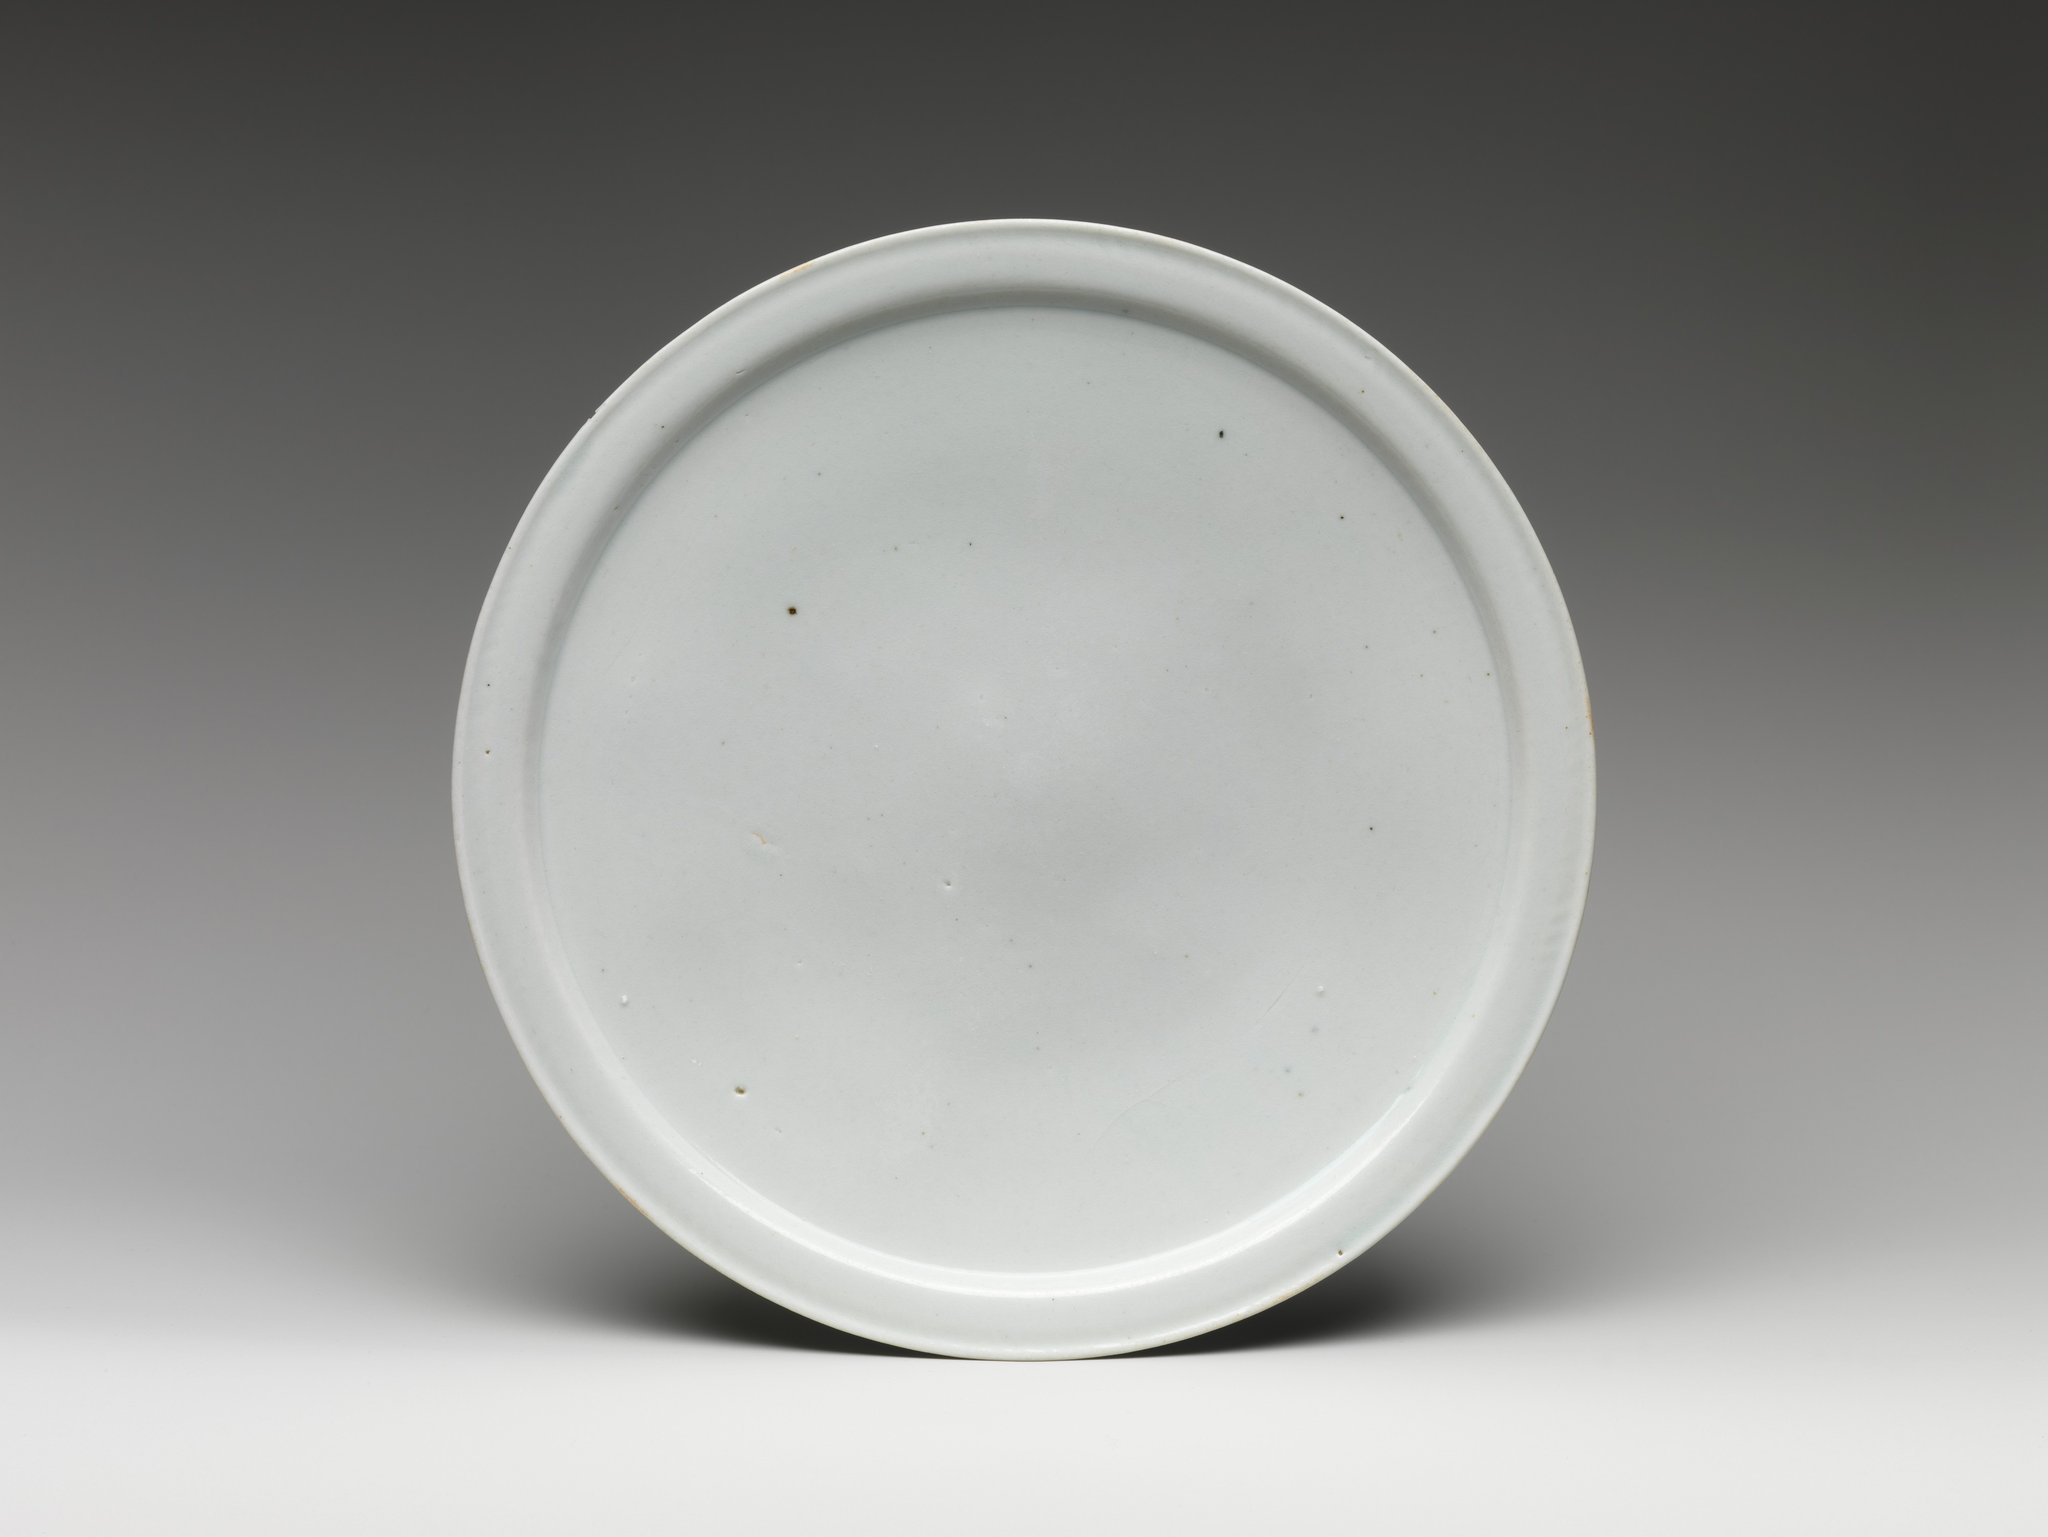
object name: dish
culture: korean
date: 1451-1500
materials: porcelain